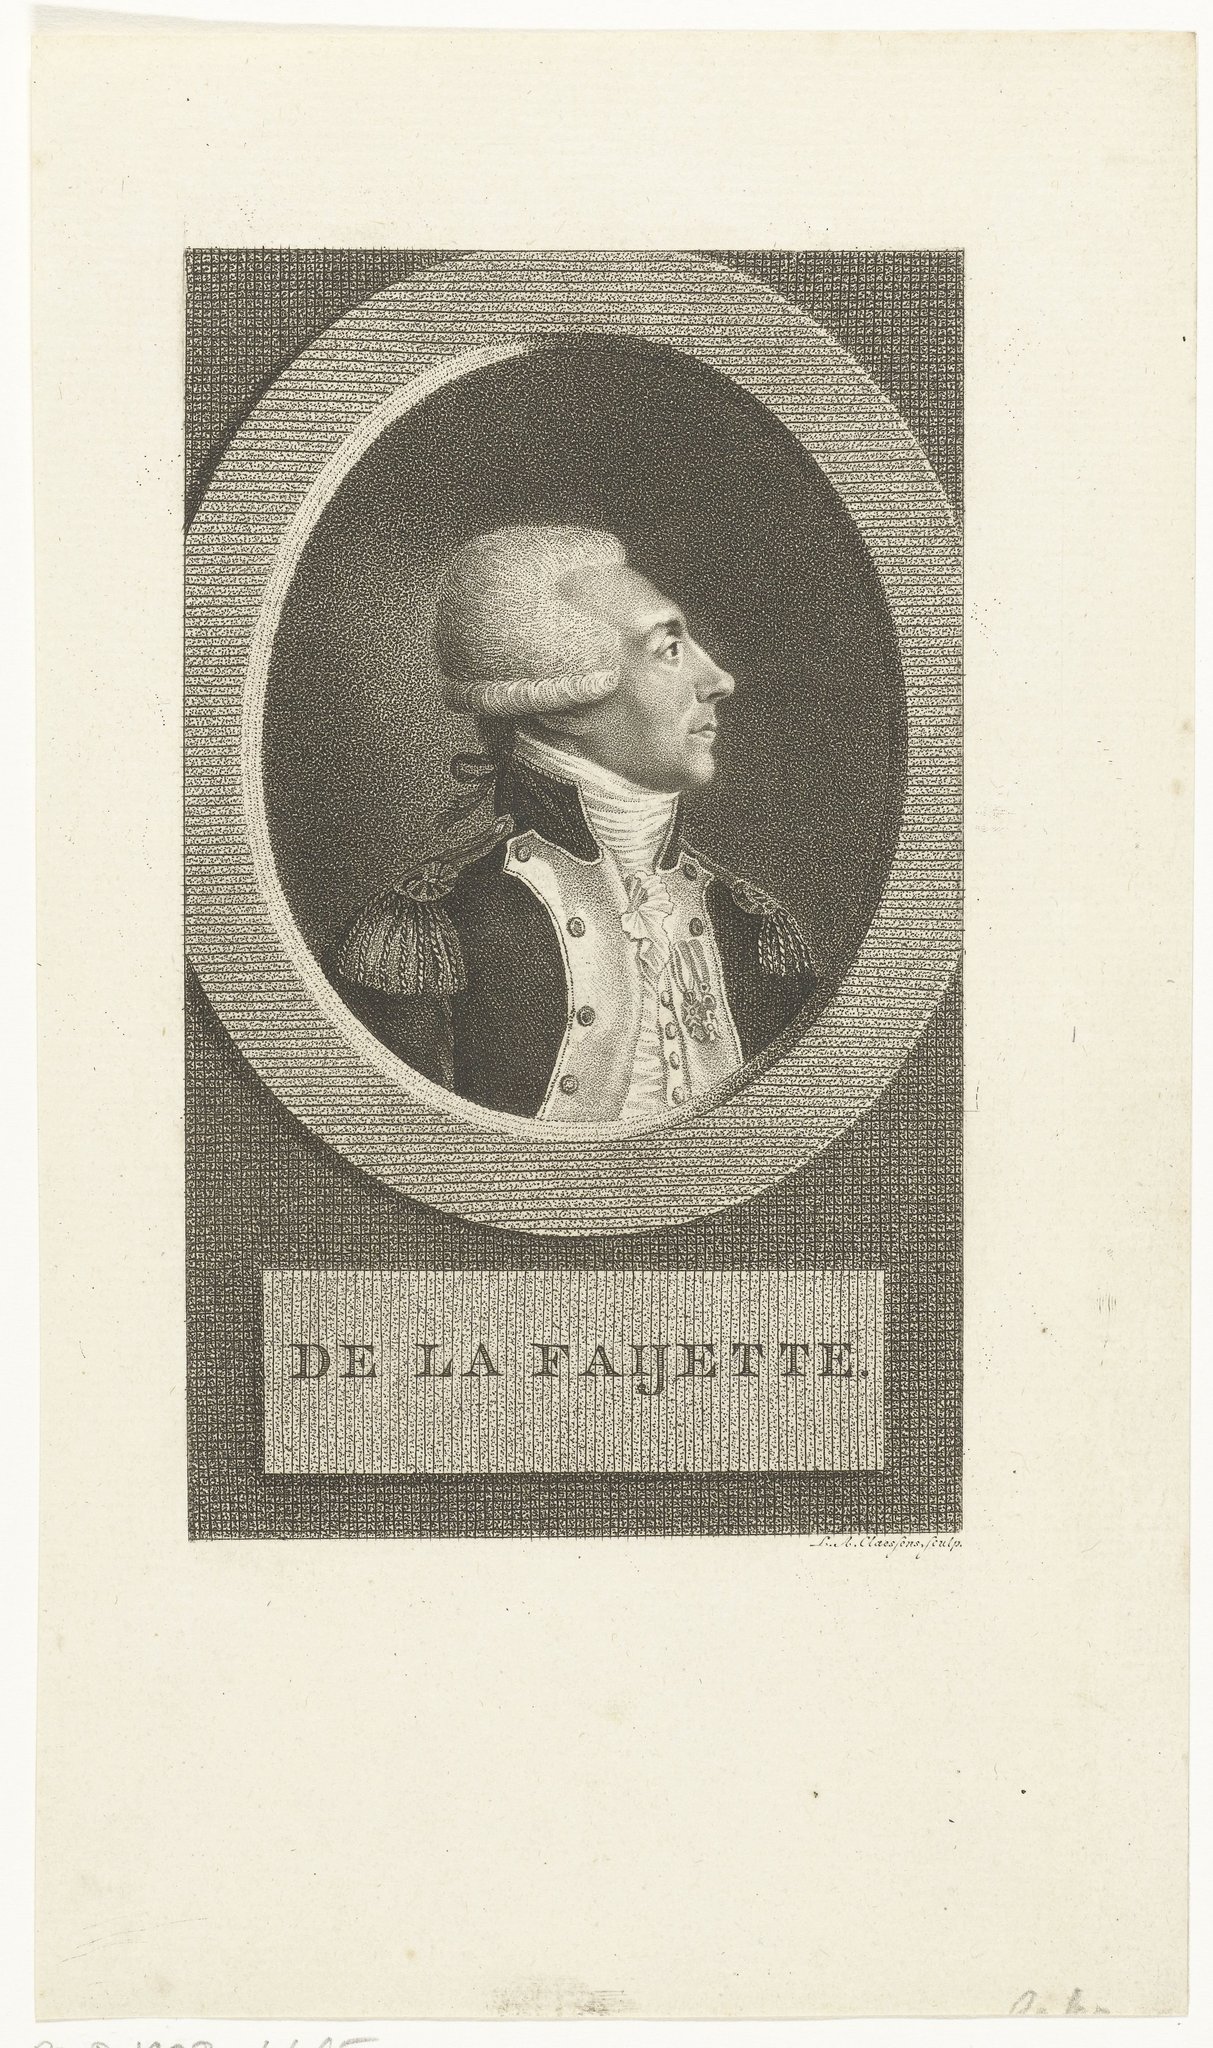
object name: print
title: Portret van Gilbert du Mortier markies de La Fayette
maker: lambertus antonius claessens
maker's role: draughtsman, print maker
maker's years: 1763-1834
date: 1792-1808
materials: paper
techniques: engraving, etching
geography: amsterdam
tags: paris, politician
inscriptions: collector's mark: Lugt 2228